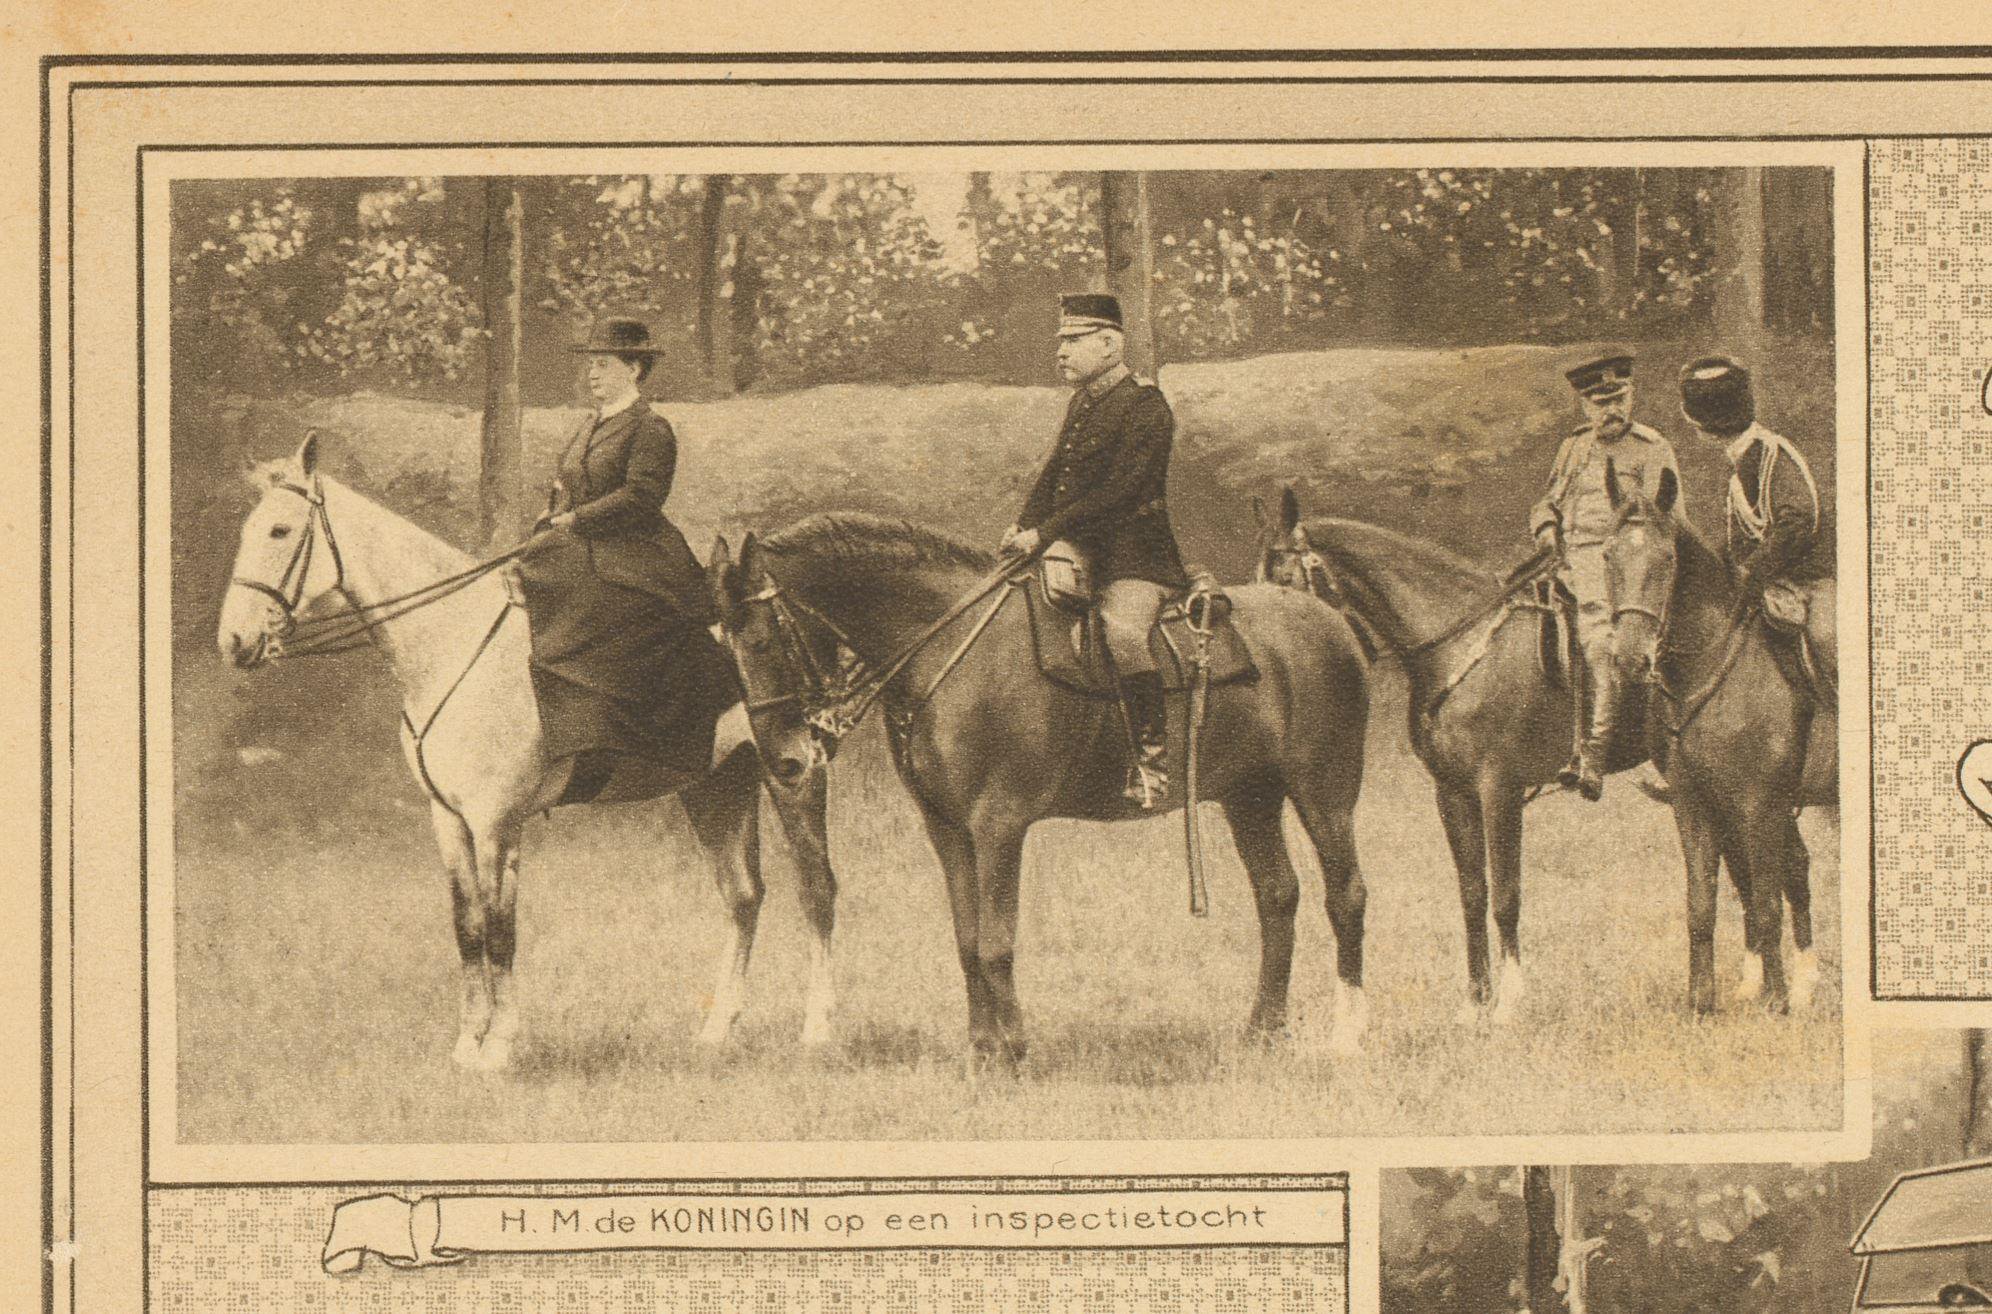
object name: album leaf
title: H. M. de Koningin op een inspectietocht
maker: Anonymous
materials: paper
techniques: rotogravure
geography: leiden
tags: the hague, print maker, wilhelmina of the netherlands, riding a horse, ass, or mule; rider, horseman, queen, netherlands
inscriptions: inscription: ‘Nederland/ in/ Mobilisatie/ Deze foto's zijn voor het grootste deel uit het/ boek: De Nederlandsche Strijdmacht en hare/ Mobilisatie van den Kapitein J. Kooiman/ (uitgever J Muusses te Purmerend), die/ deze - met goedvinden van den Opperbevel-/ hebber - welwillend aan ons ten gebruike/ heeft afgestaan.’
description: Deze prent maakt deel uit van een album.